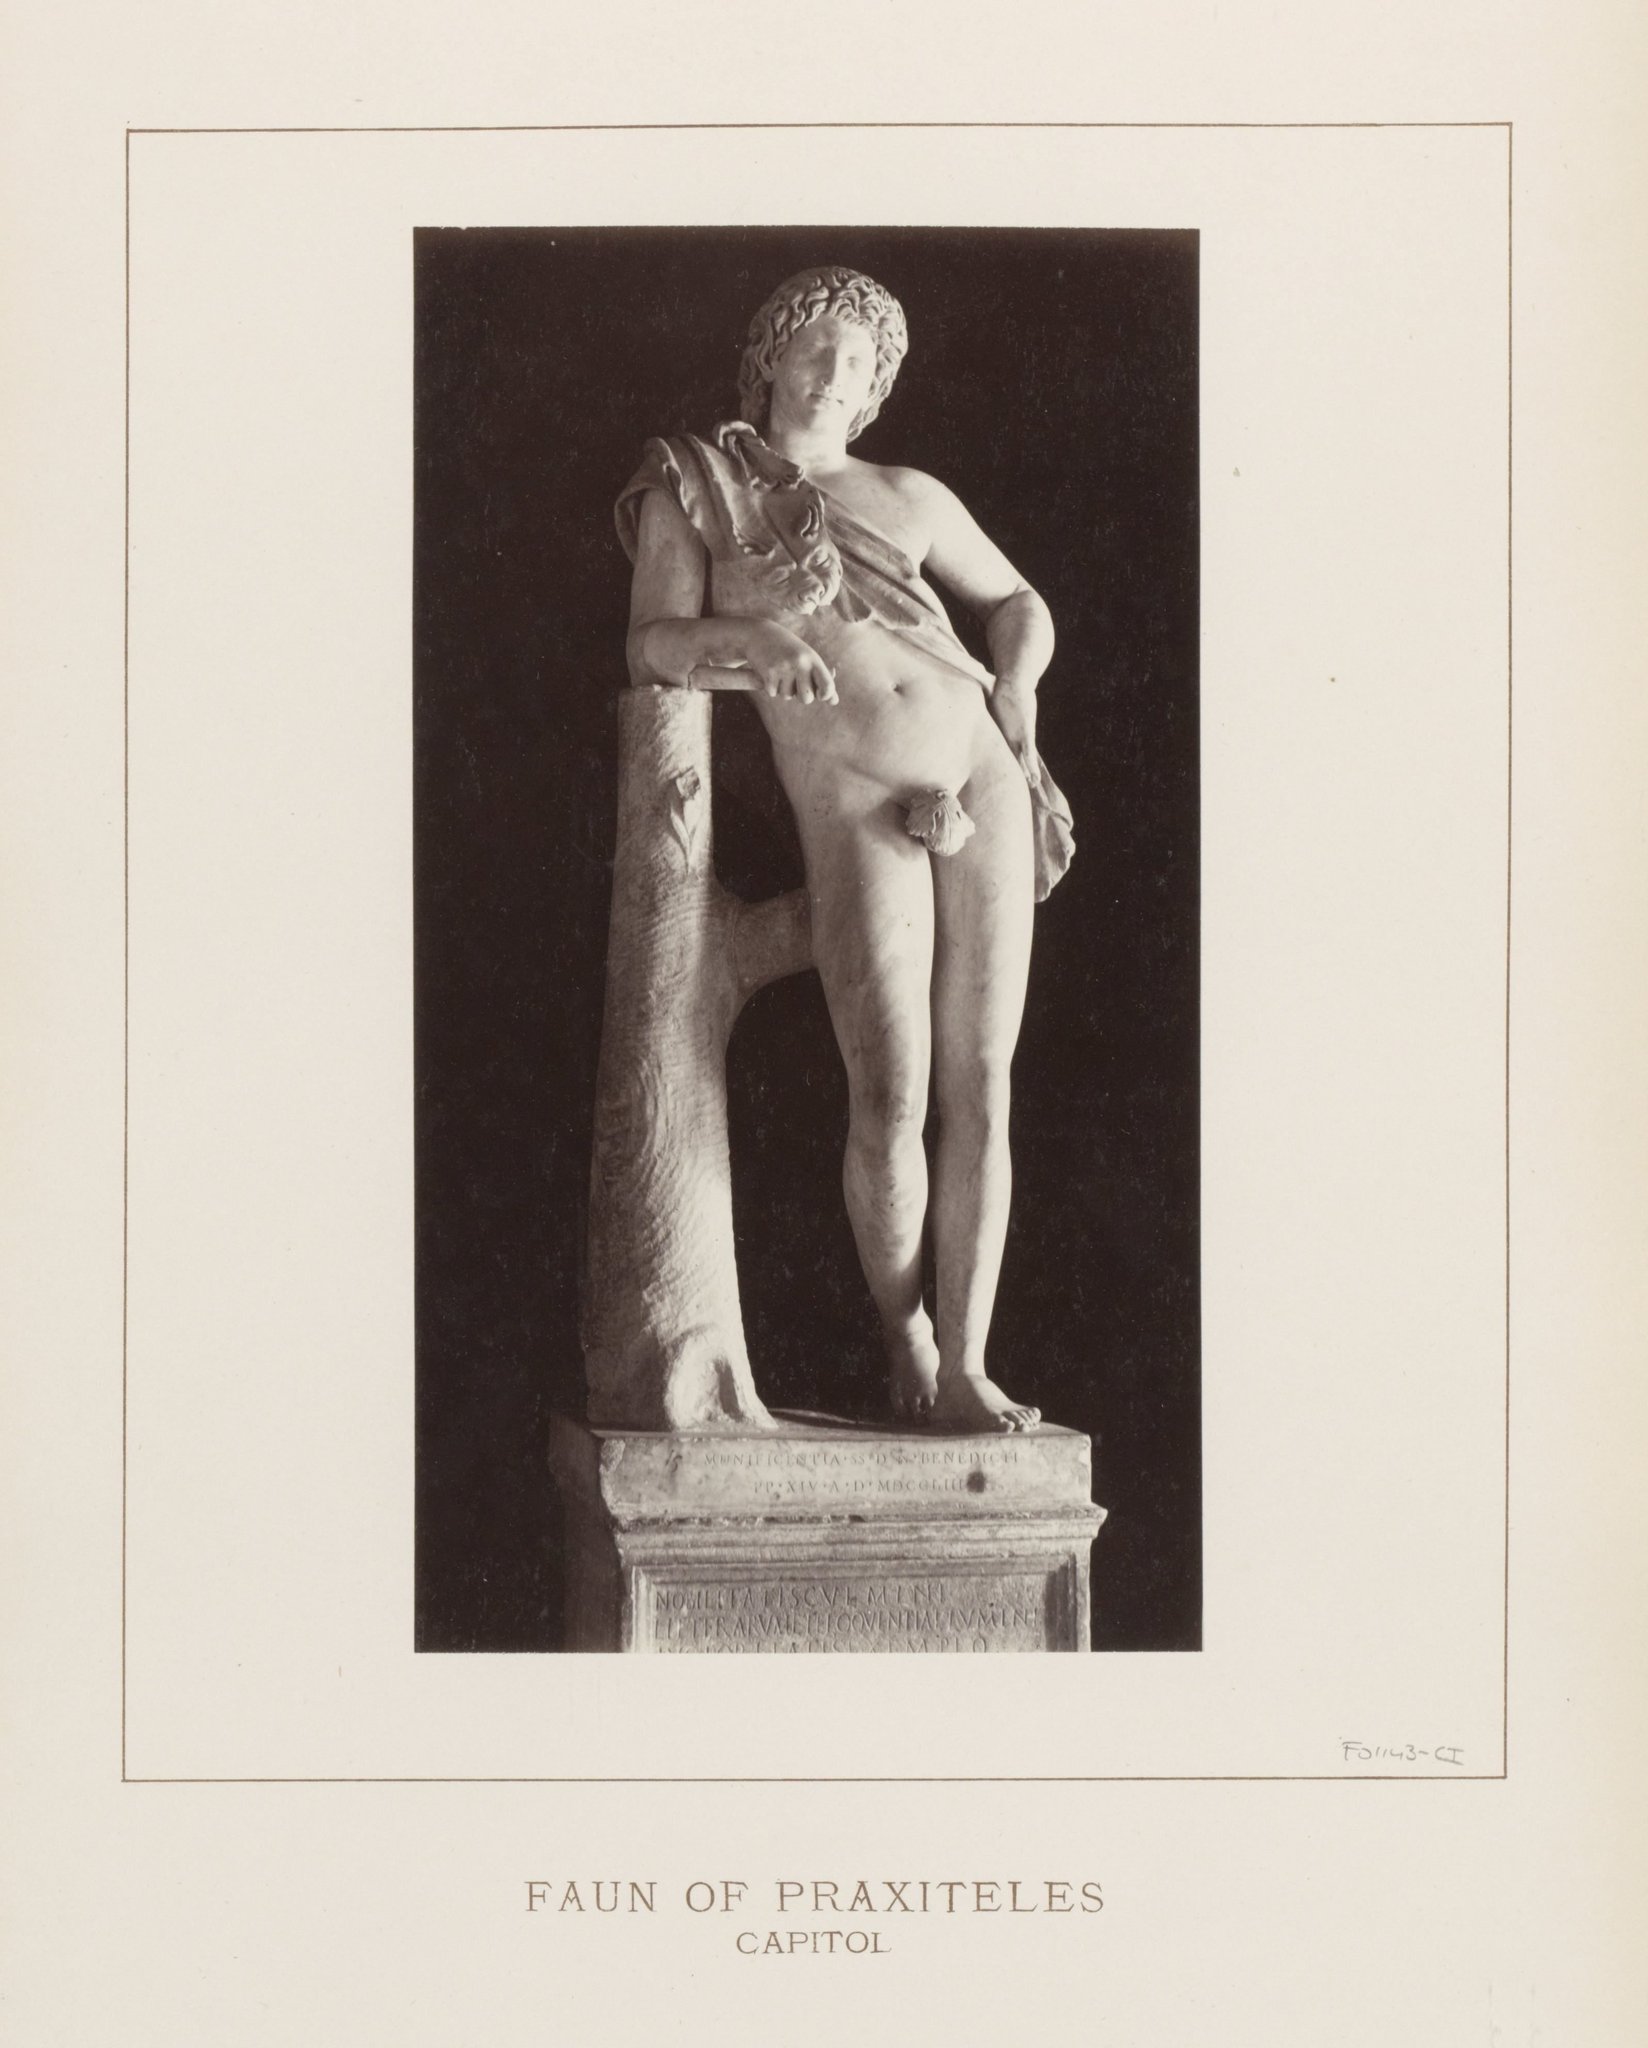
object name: photograph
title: Faun of Praxiteles, Capitol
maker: Anonymous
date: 1860-1900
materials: photographic support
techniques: albumen print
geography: vatican city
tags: youth, adolescent, piece of sculpture, reproduction of a piece of sculpture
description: Onderdeel van Fotoalbum met opnames van bezienswaardigheden en kunstwerken in Rome.